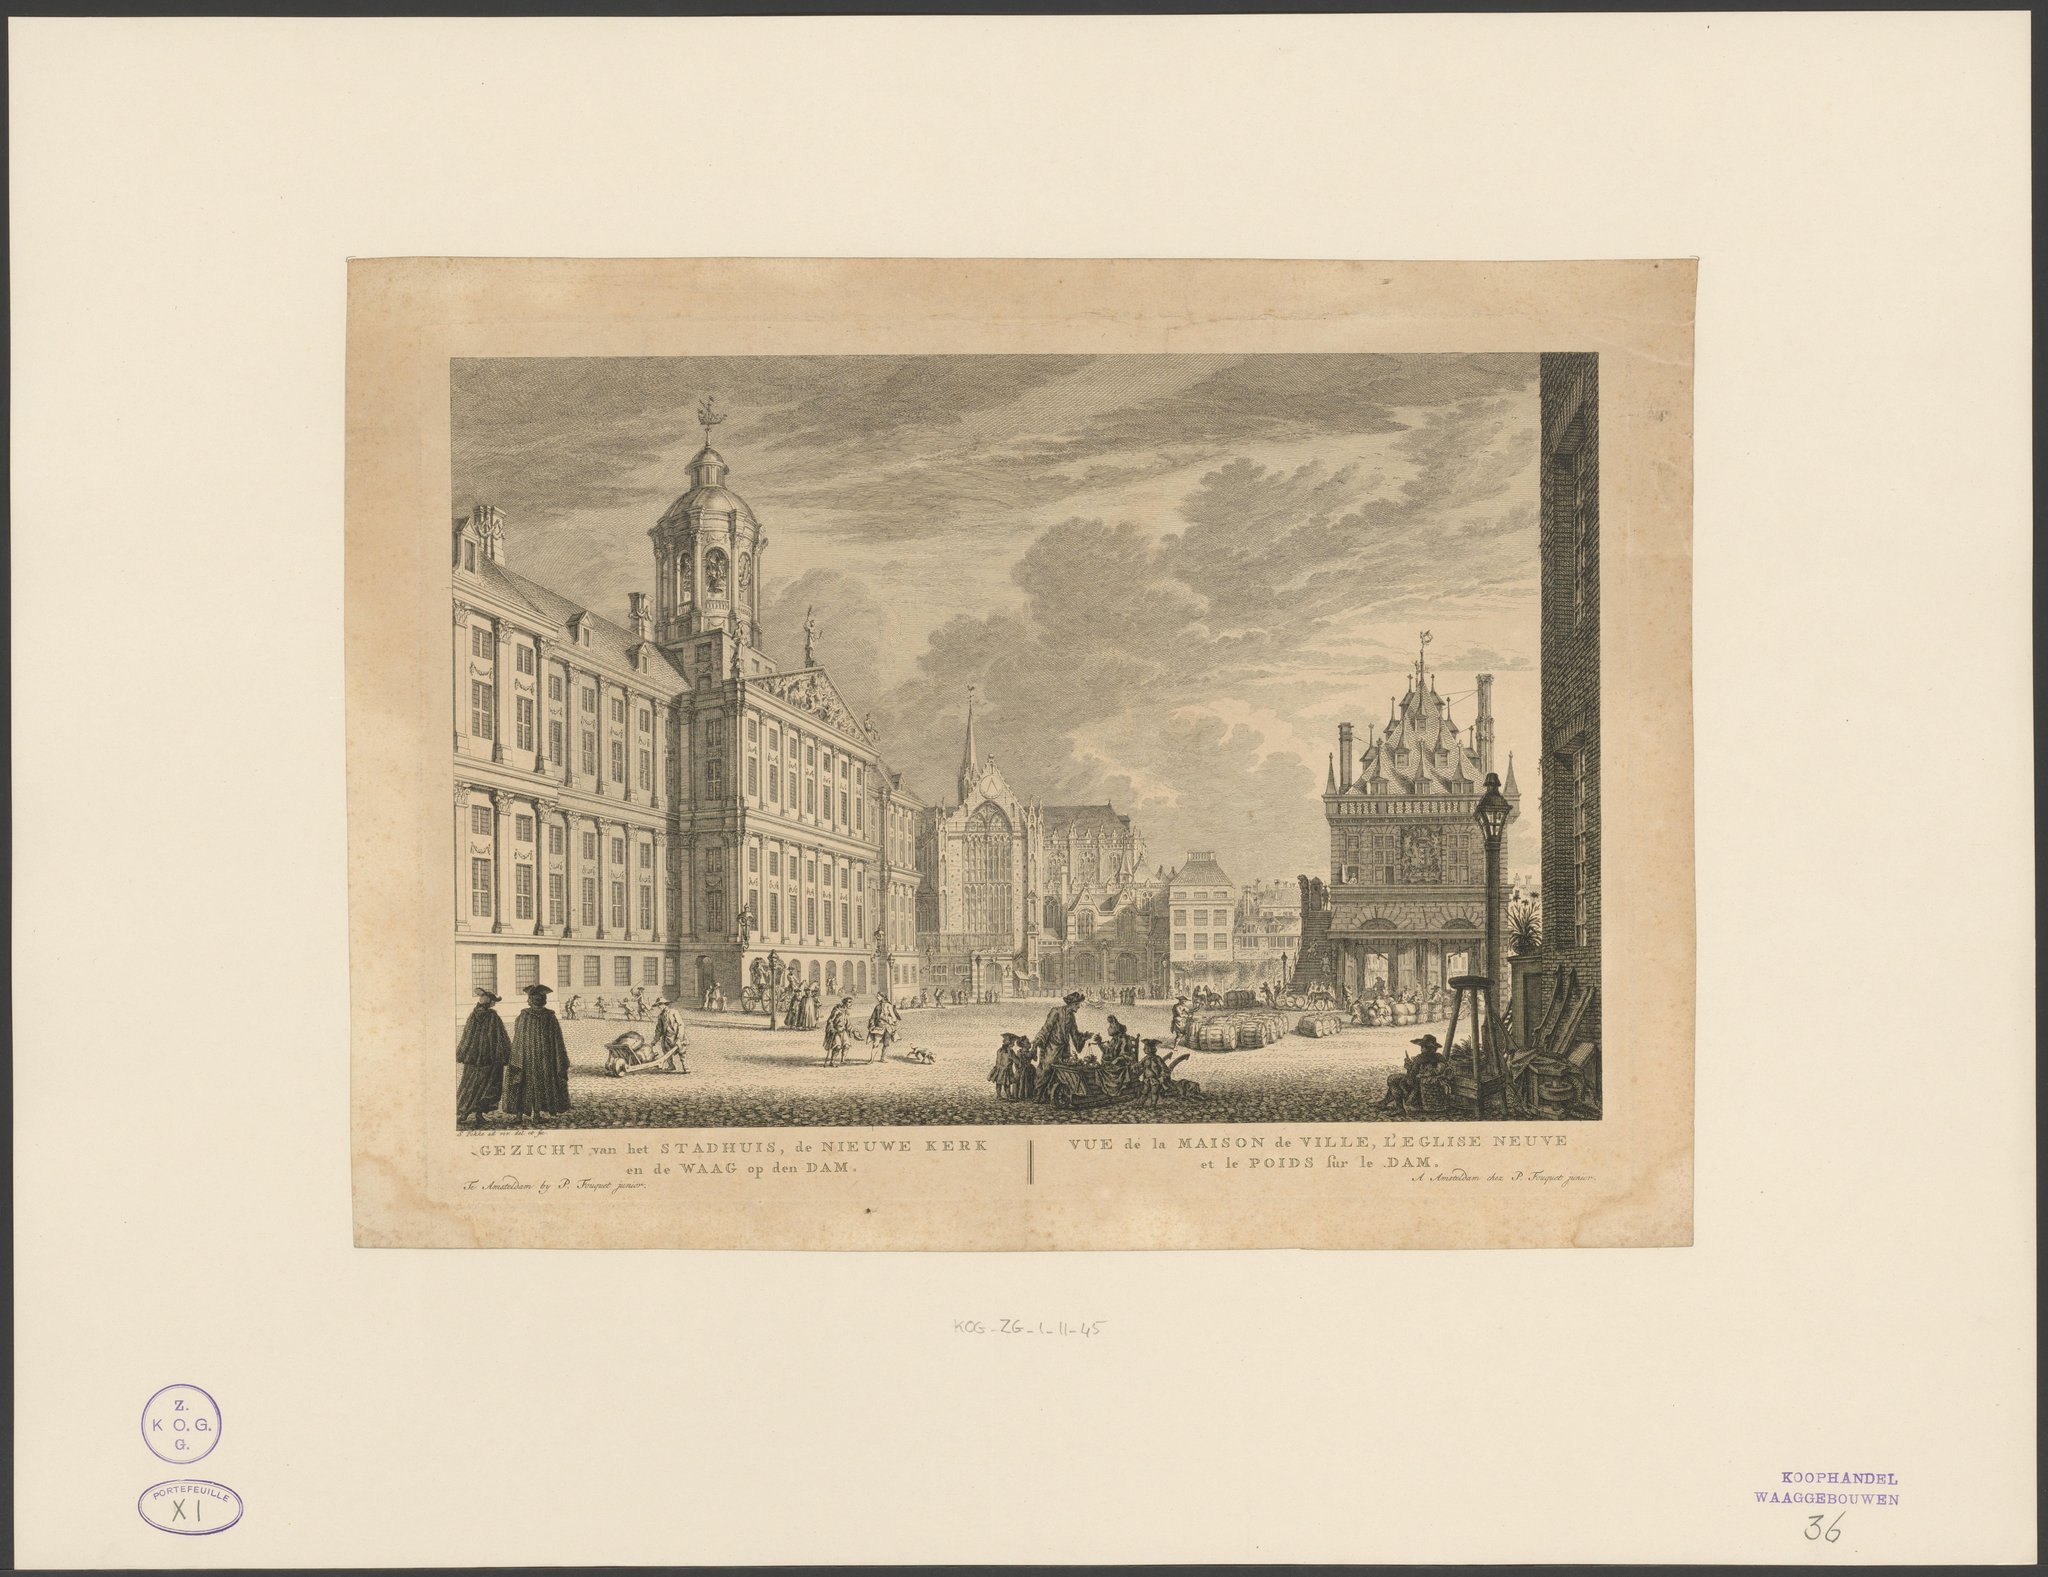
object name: print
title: Gezicht van het Stadhuis, de Nieuwe Kerk en de Waag op den Dam / Vue de la Maison de Ville, l'eglise neuve et le poids sur le Dam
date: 1753-1800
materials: paper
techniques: engraving, etching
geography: amsterdam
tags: townhall, weigh-house, city-view in general; 'veduta' (+ city(-scape) with figures, staffage)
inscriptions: stamp, collector's mark: Lugt 1641, stamp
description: Gezicht op de Dam te Amsterdam, met de Waag, het nieuwe Stadhuis en de Nieuwe Kerk. Onderwerpsrubrieken binnen de Atlas Zeden en Gewoonten: Handel, Nijverheid en Verkeer, Koophandel, Waaggebouwen.